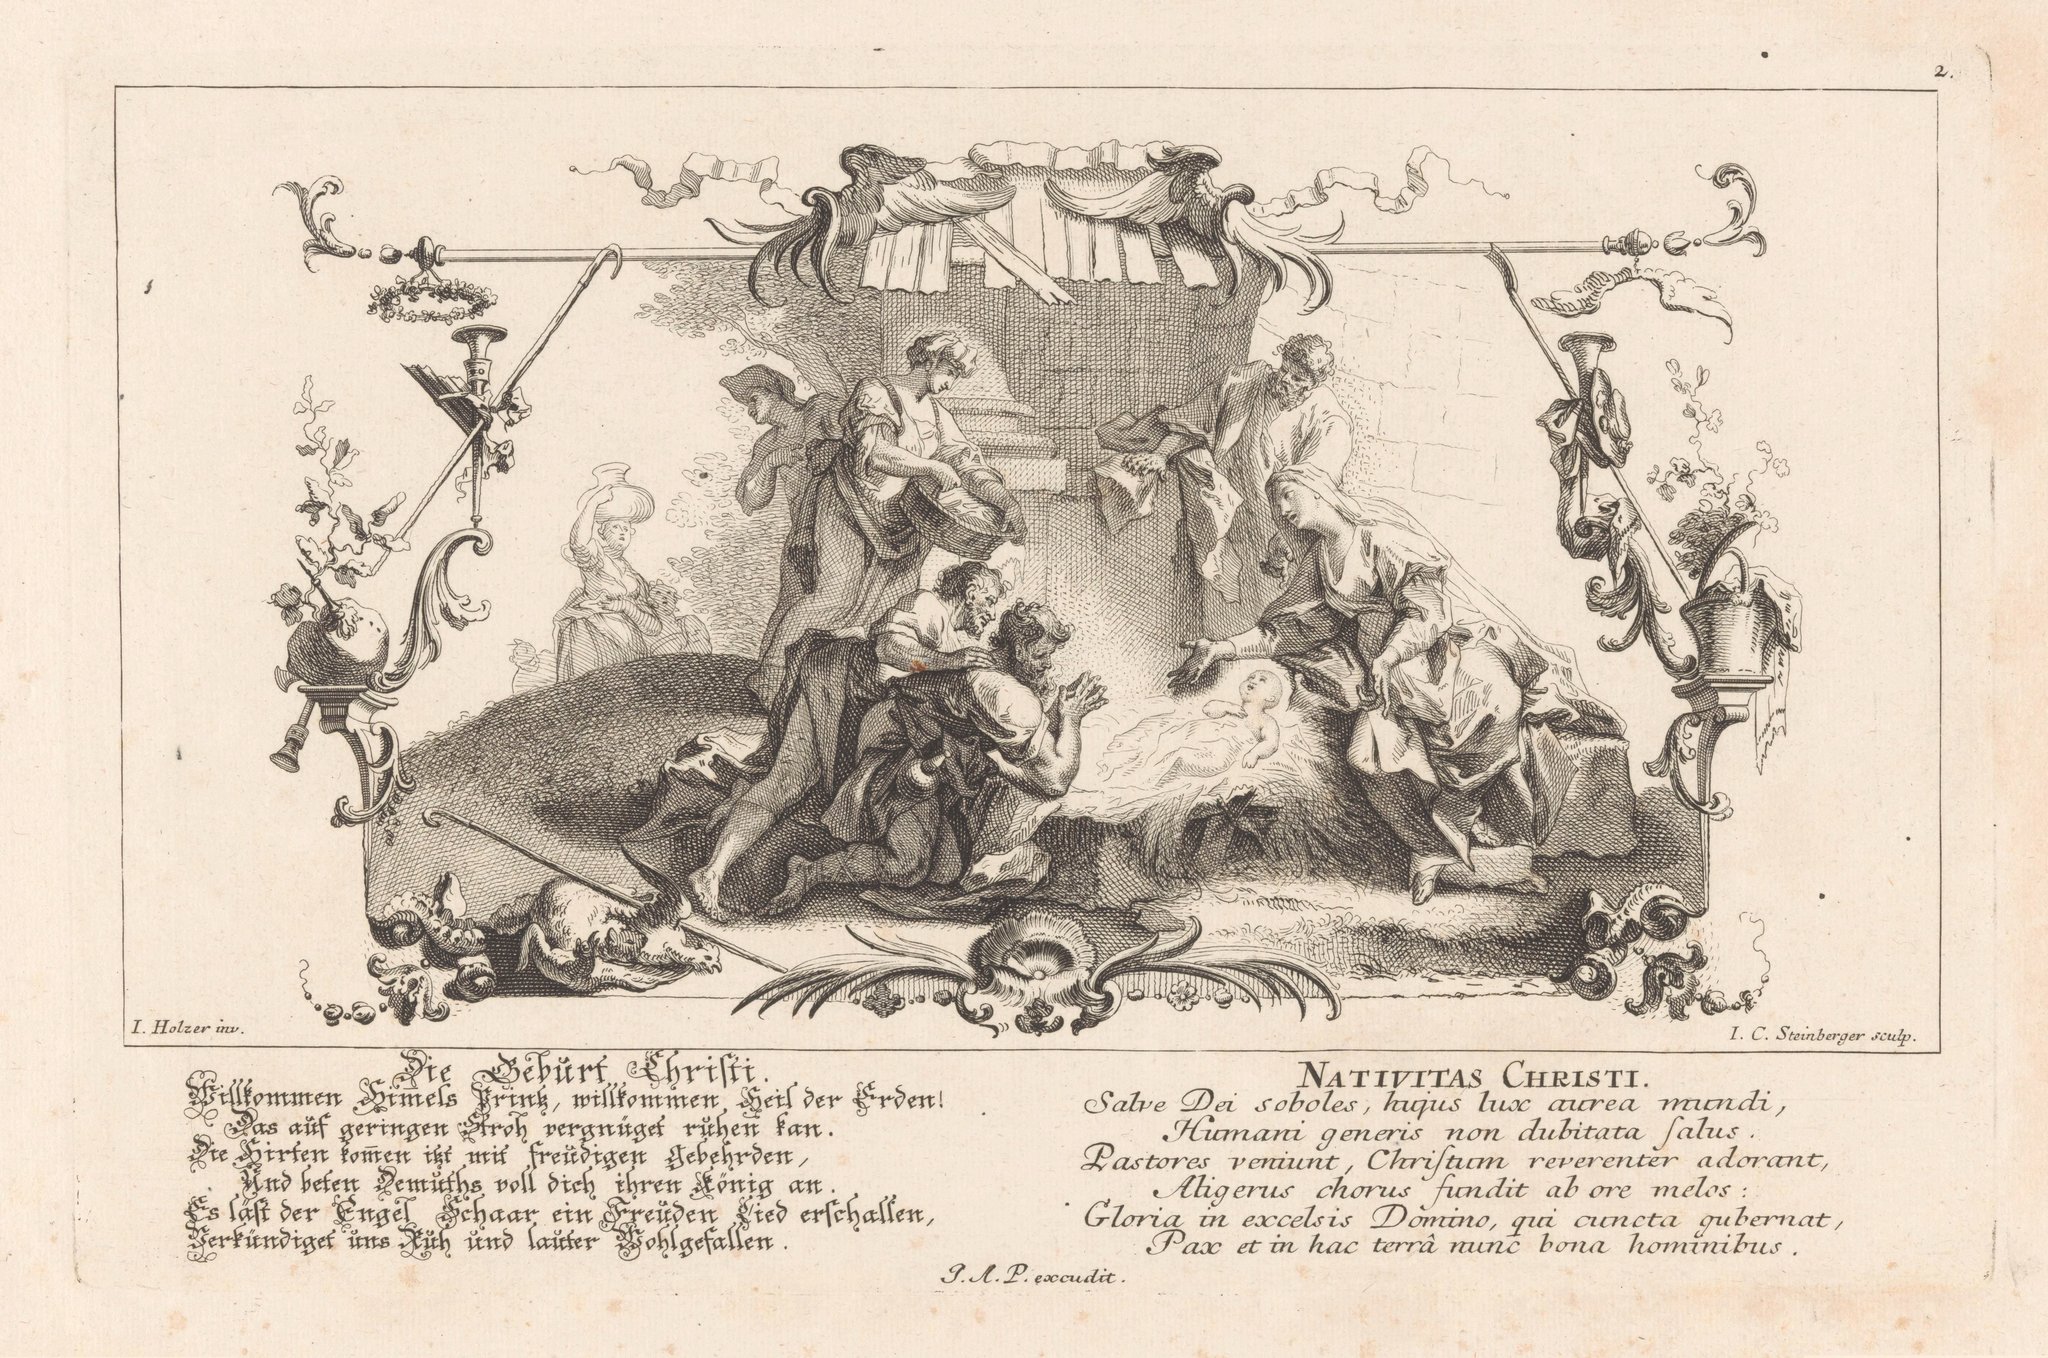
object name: ornament print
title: Geboorte van Christus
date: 1719-1727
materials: paper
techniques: etching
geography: augsburg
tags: adoration of the christ-child by mary and joseph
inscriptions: collector's mark: Lugt 2228, collector's mark: Lugt 2760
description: De geboorte van Christus. Maria en Jozef, twee mannen en een vrouw aanbidden het Christuskind dat in de kribbe ligt. In het landschap op de achtergrond komen een vrouw met een kruik op het hoofd en twee andere figuren aanlopen. Rondom de voorstelling een rocaille omlijsting. In de ondermarge tweemaal een zevenregelige Duitse en Latijnse tekst.